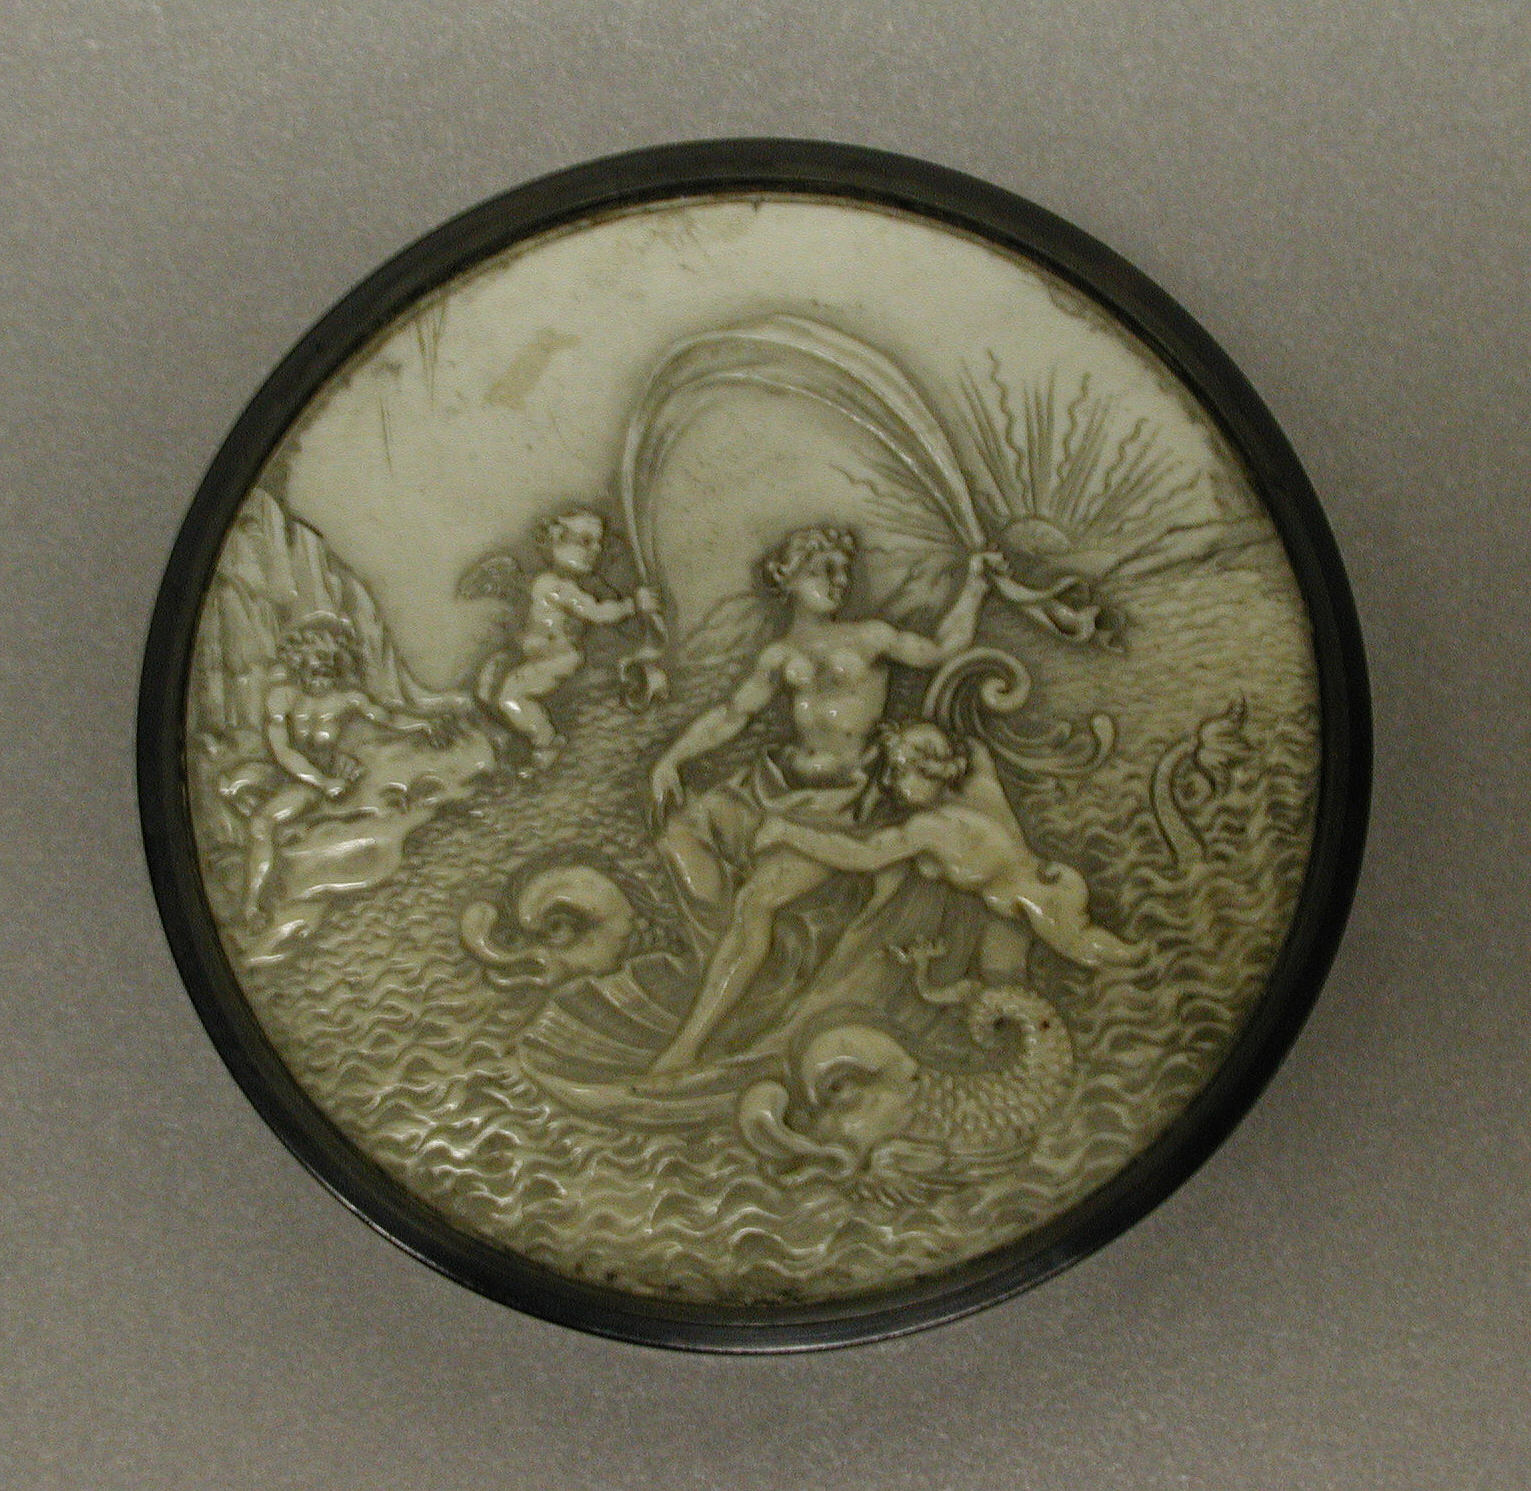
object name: snuffbox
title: Venus Rising from the Sea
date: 1801-1900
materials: ivory, shell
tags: putti,venus,fish,sun